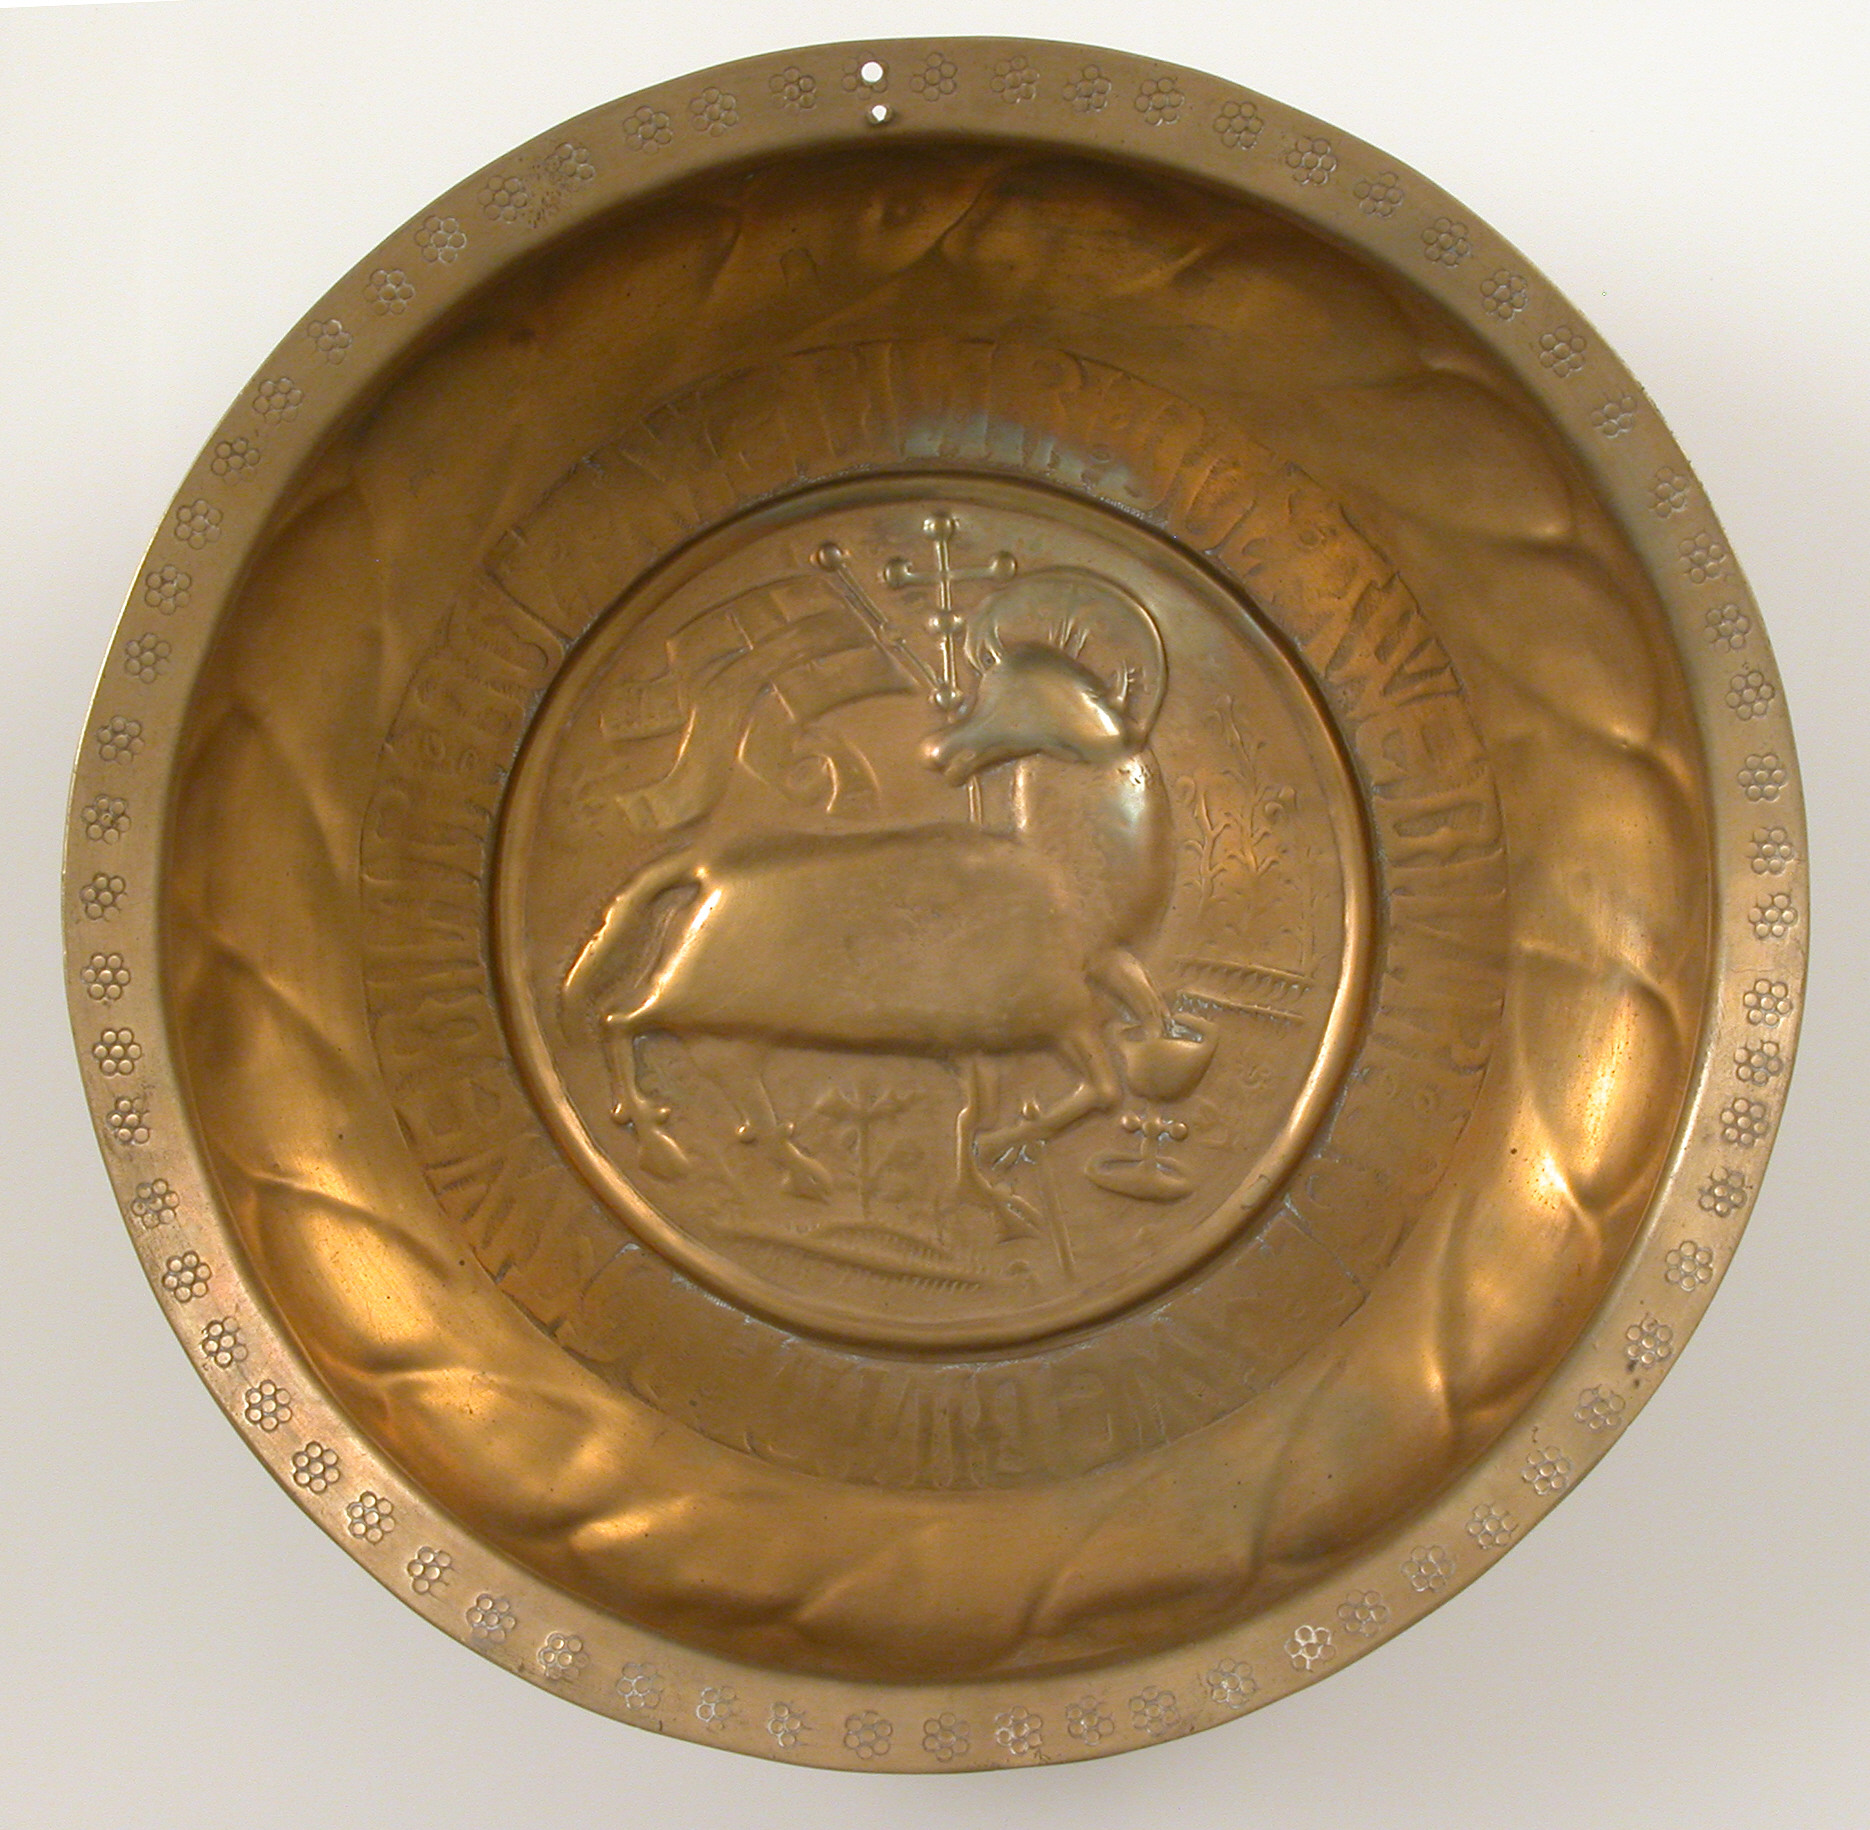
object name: dish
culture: german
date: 1501-1533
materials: brass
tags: animals